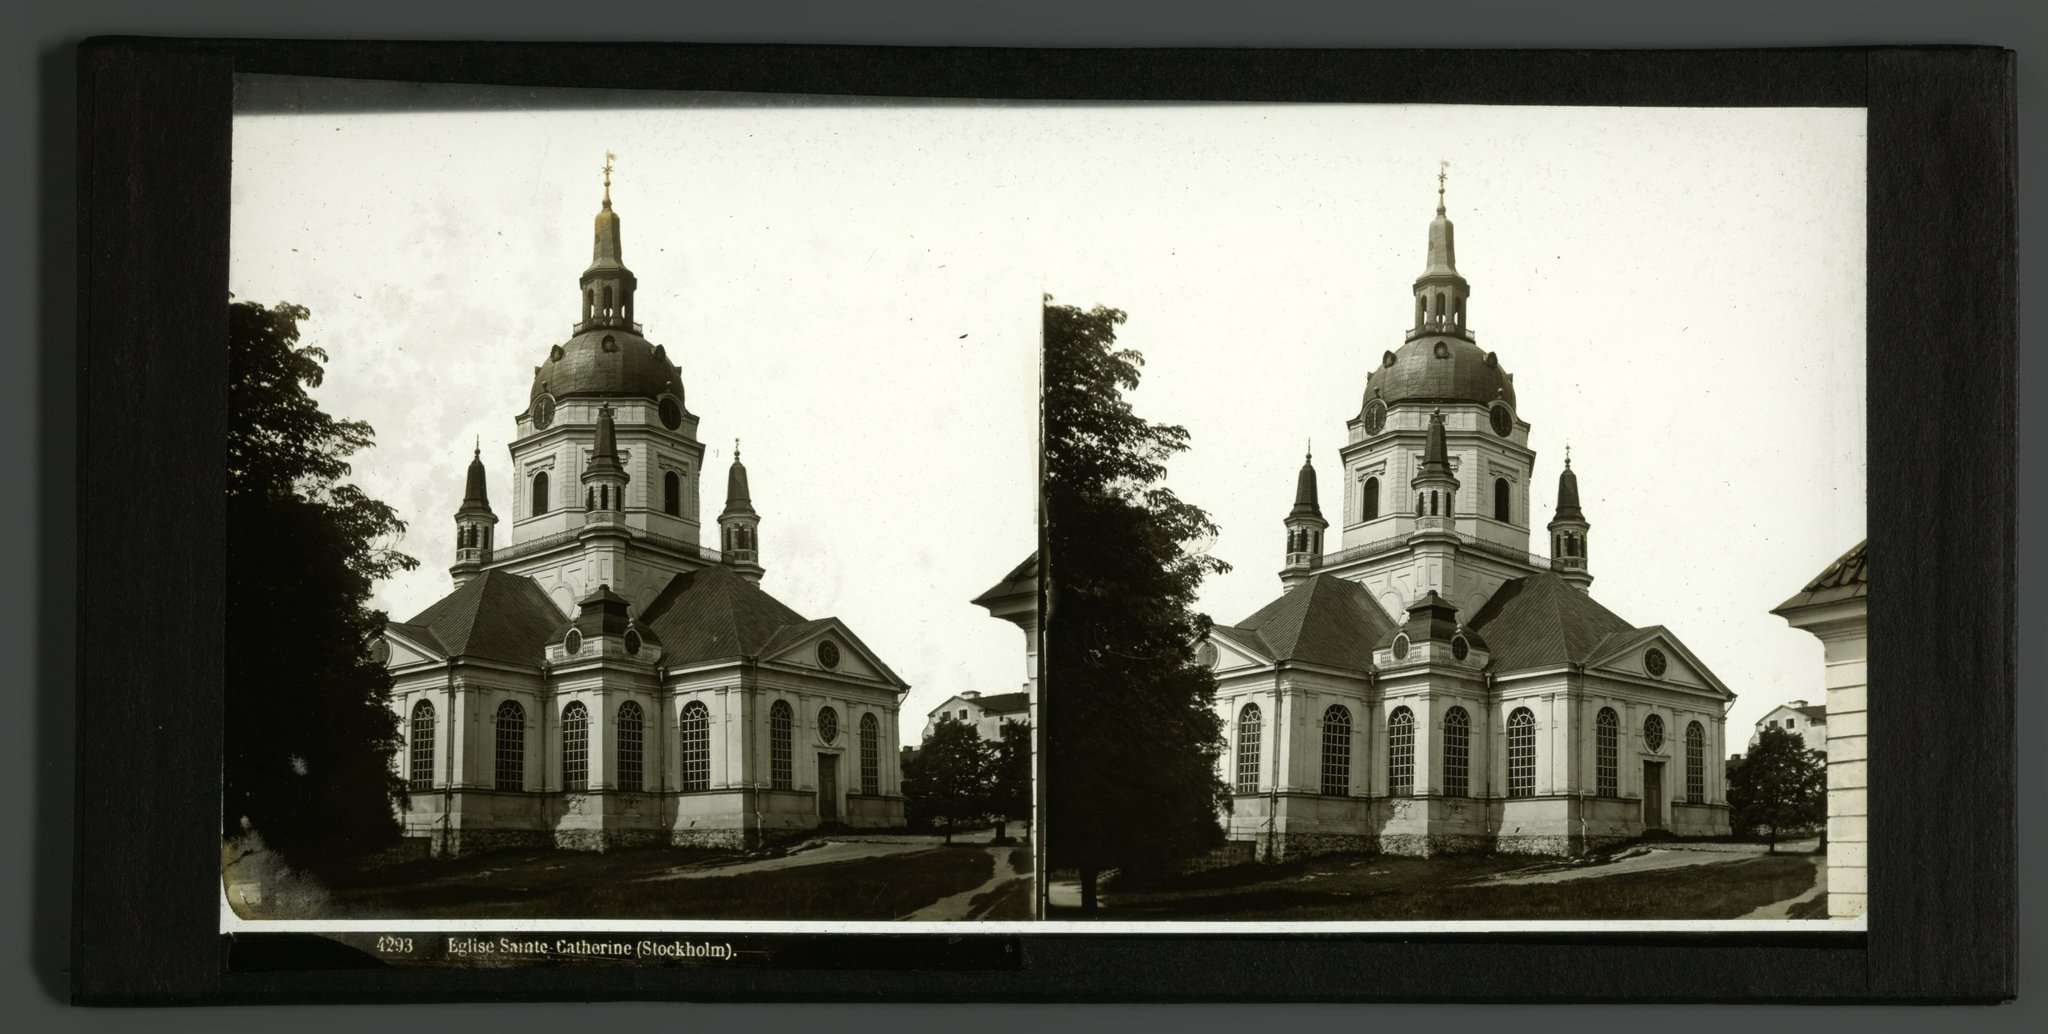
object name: stereoscopic photograph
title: Eglise Sainte-Catherine (Stockholm)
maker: ferrier père-fils et soulier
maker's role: publisher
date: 1860-1890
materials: glass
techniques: slide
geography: stockholm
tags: church (exterior)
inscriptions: number: ‘4293’